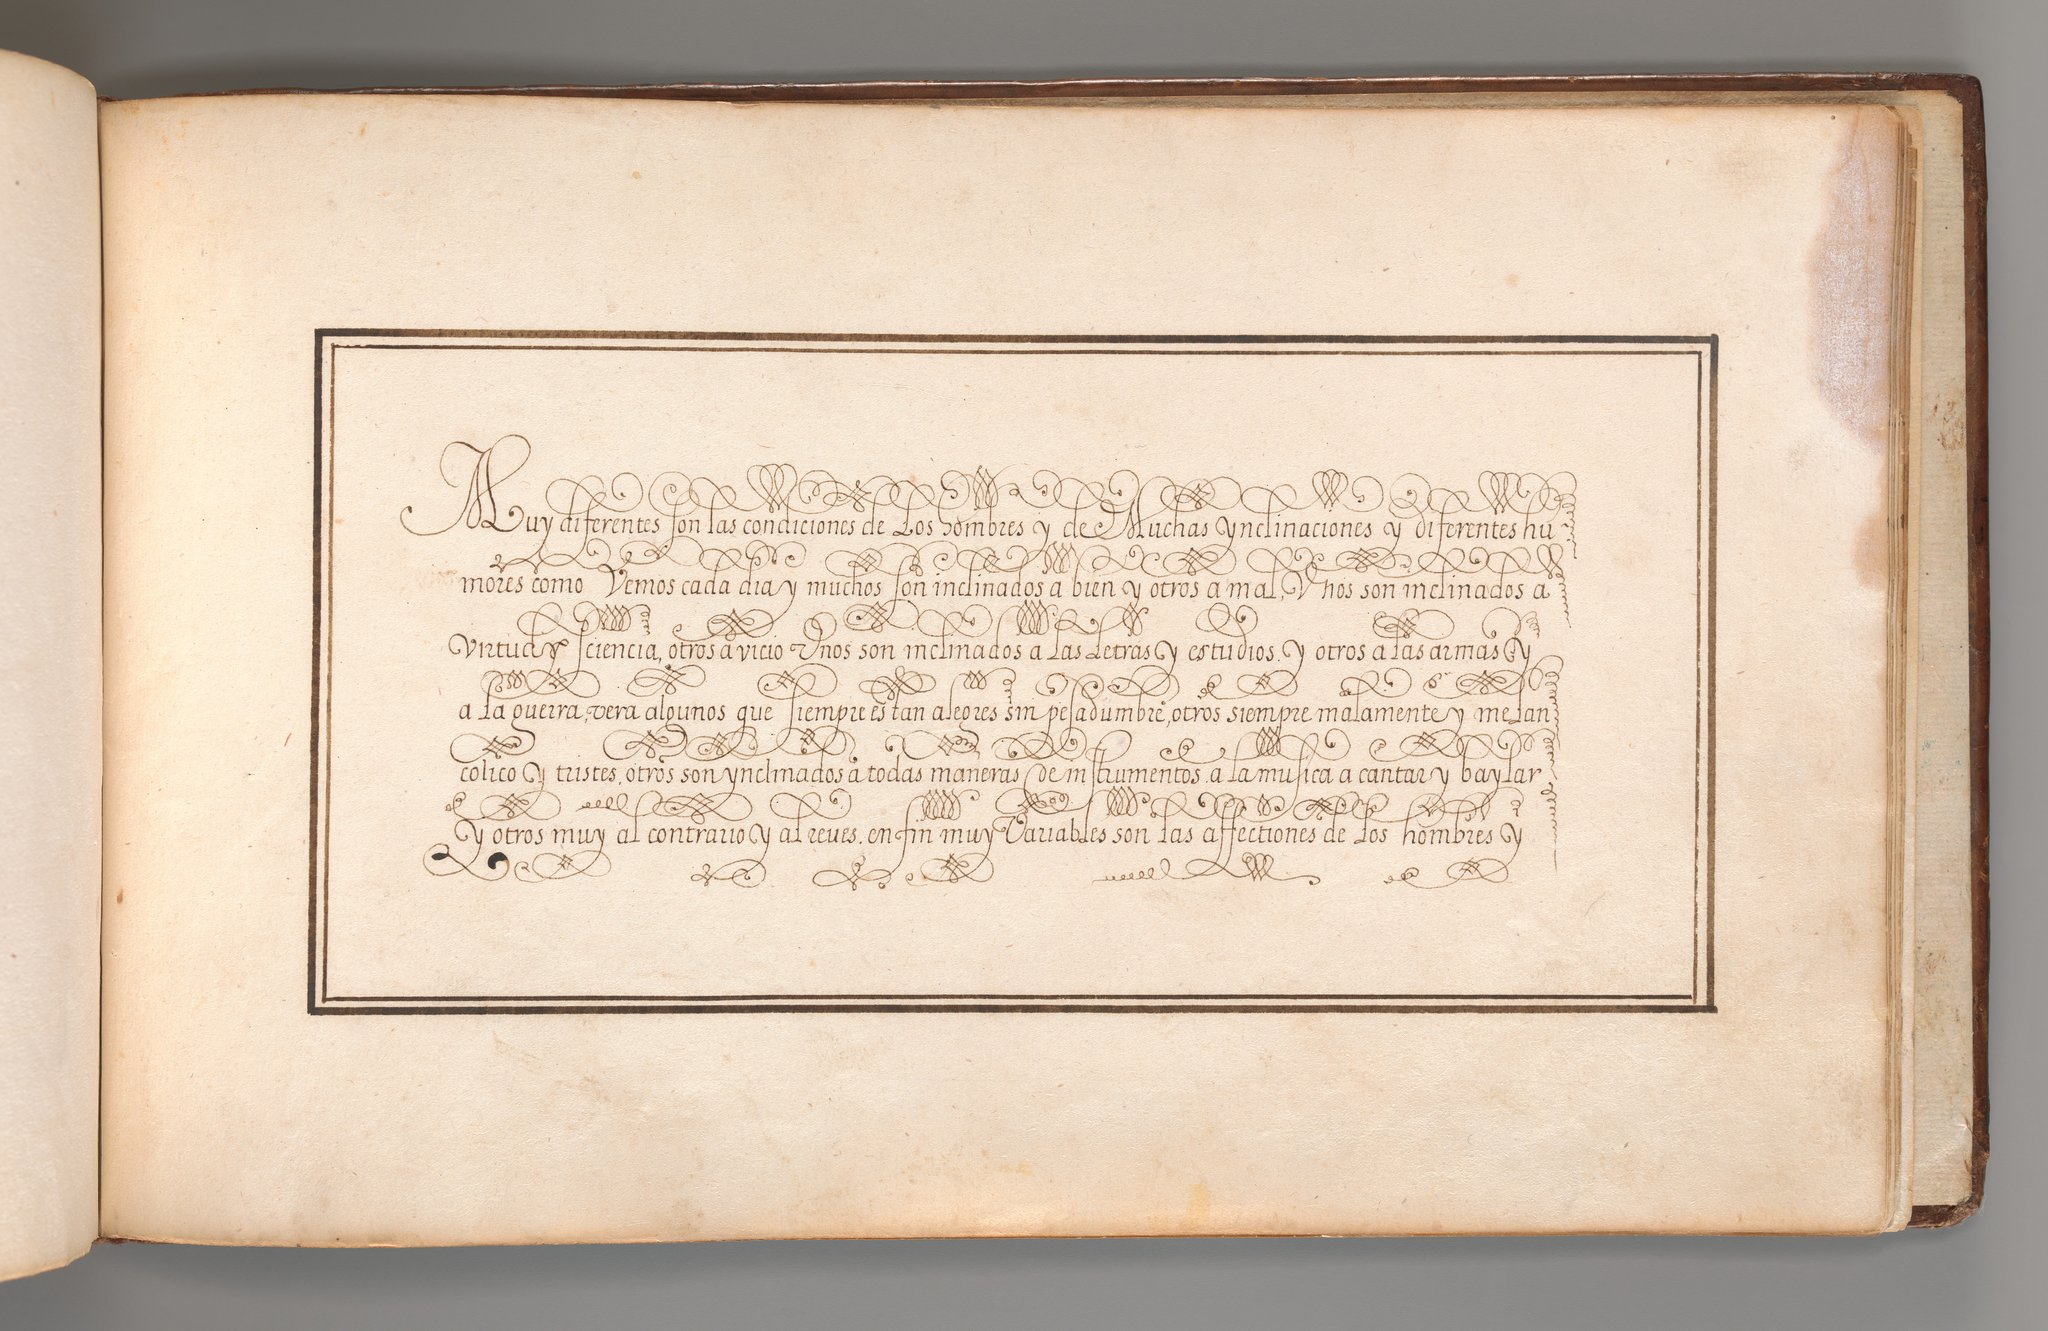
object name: album print ornament architecture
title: Calligraphic Exercise in Spanish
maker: Anonymous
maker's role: artist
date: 1601-1633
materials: ink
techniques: pen